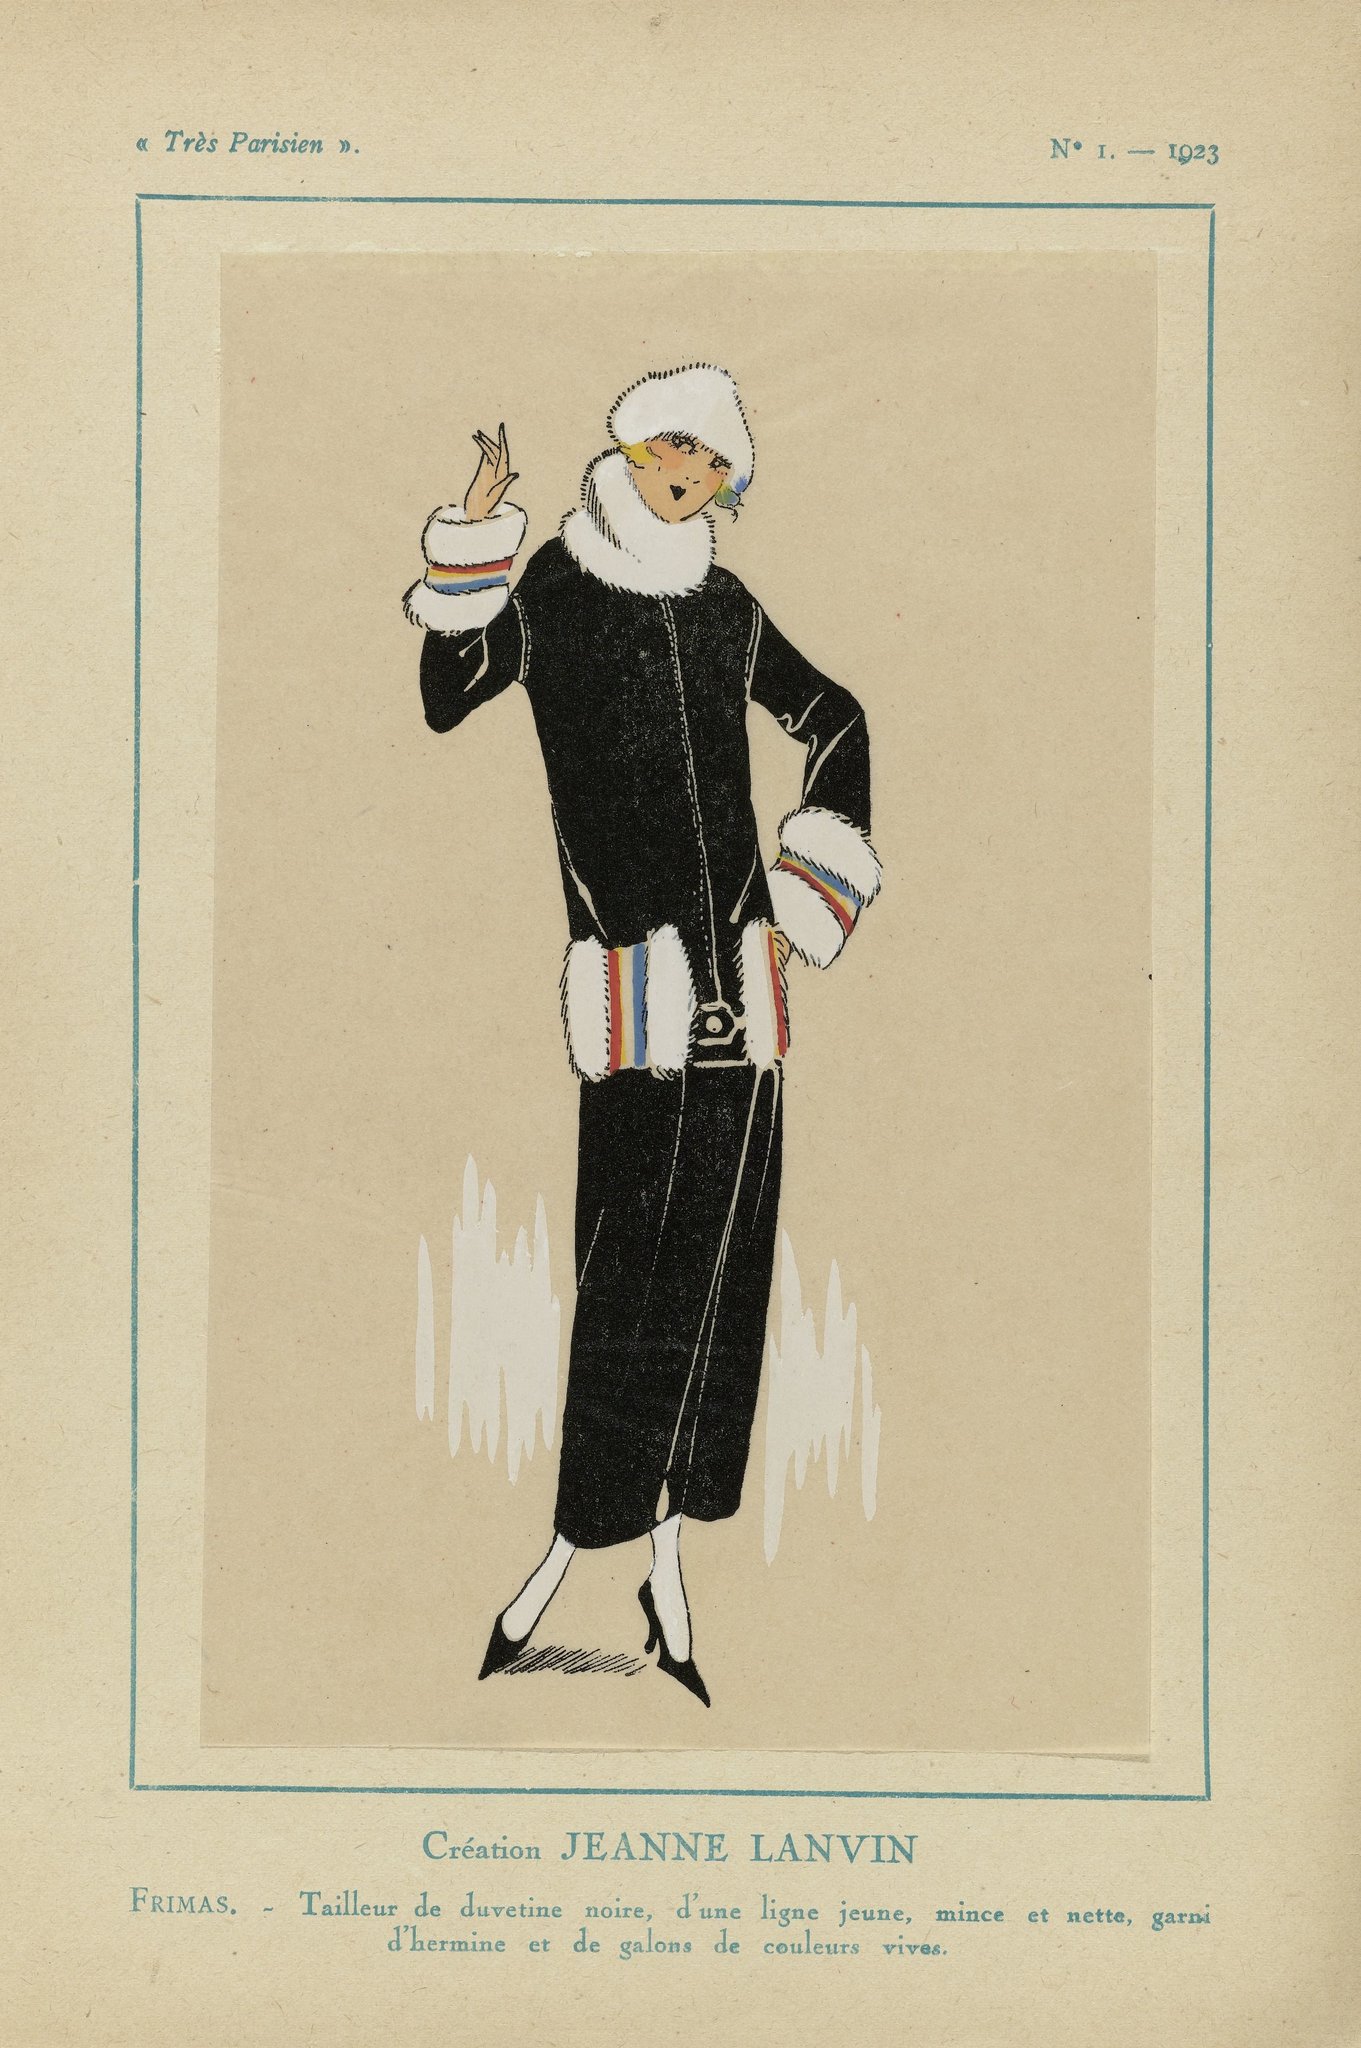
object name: fashion print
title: Très Parisien, 1923, No 1: Création JEANNE LANVIN...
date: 1923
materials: paper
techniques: hand coloring, letterpress printing, lithography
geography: paris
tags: clothing for the upper part of the body (+ women's clothes), border, ribbon, braid (+ fur used for clothes), fashion plates, skirt (+ women's clothes), head-gear: cap (+ fur used for clothes)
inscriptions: caption: ‘Création JEANNE LANVIN / FRIMAS. - Tailleur de duvetine noire, d'une ligne jeune, mince et nette, garni d' hermine et de galons de couleurs vives.’, title: ‘Très Parisien / No 1. - 1923’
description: Slank mantelpak (tailleur) van zwart duvetine, afgezet met hermelijn. Muts van hermelijn. Prent uit het modetijdschrift Très Parisien (1920-1936).